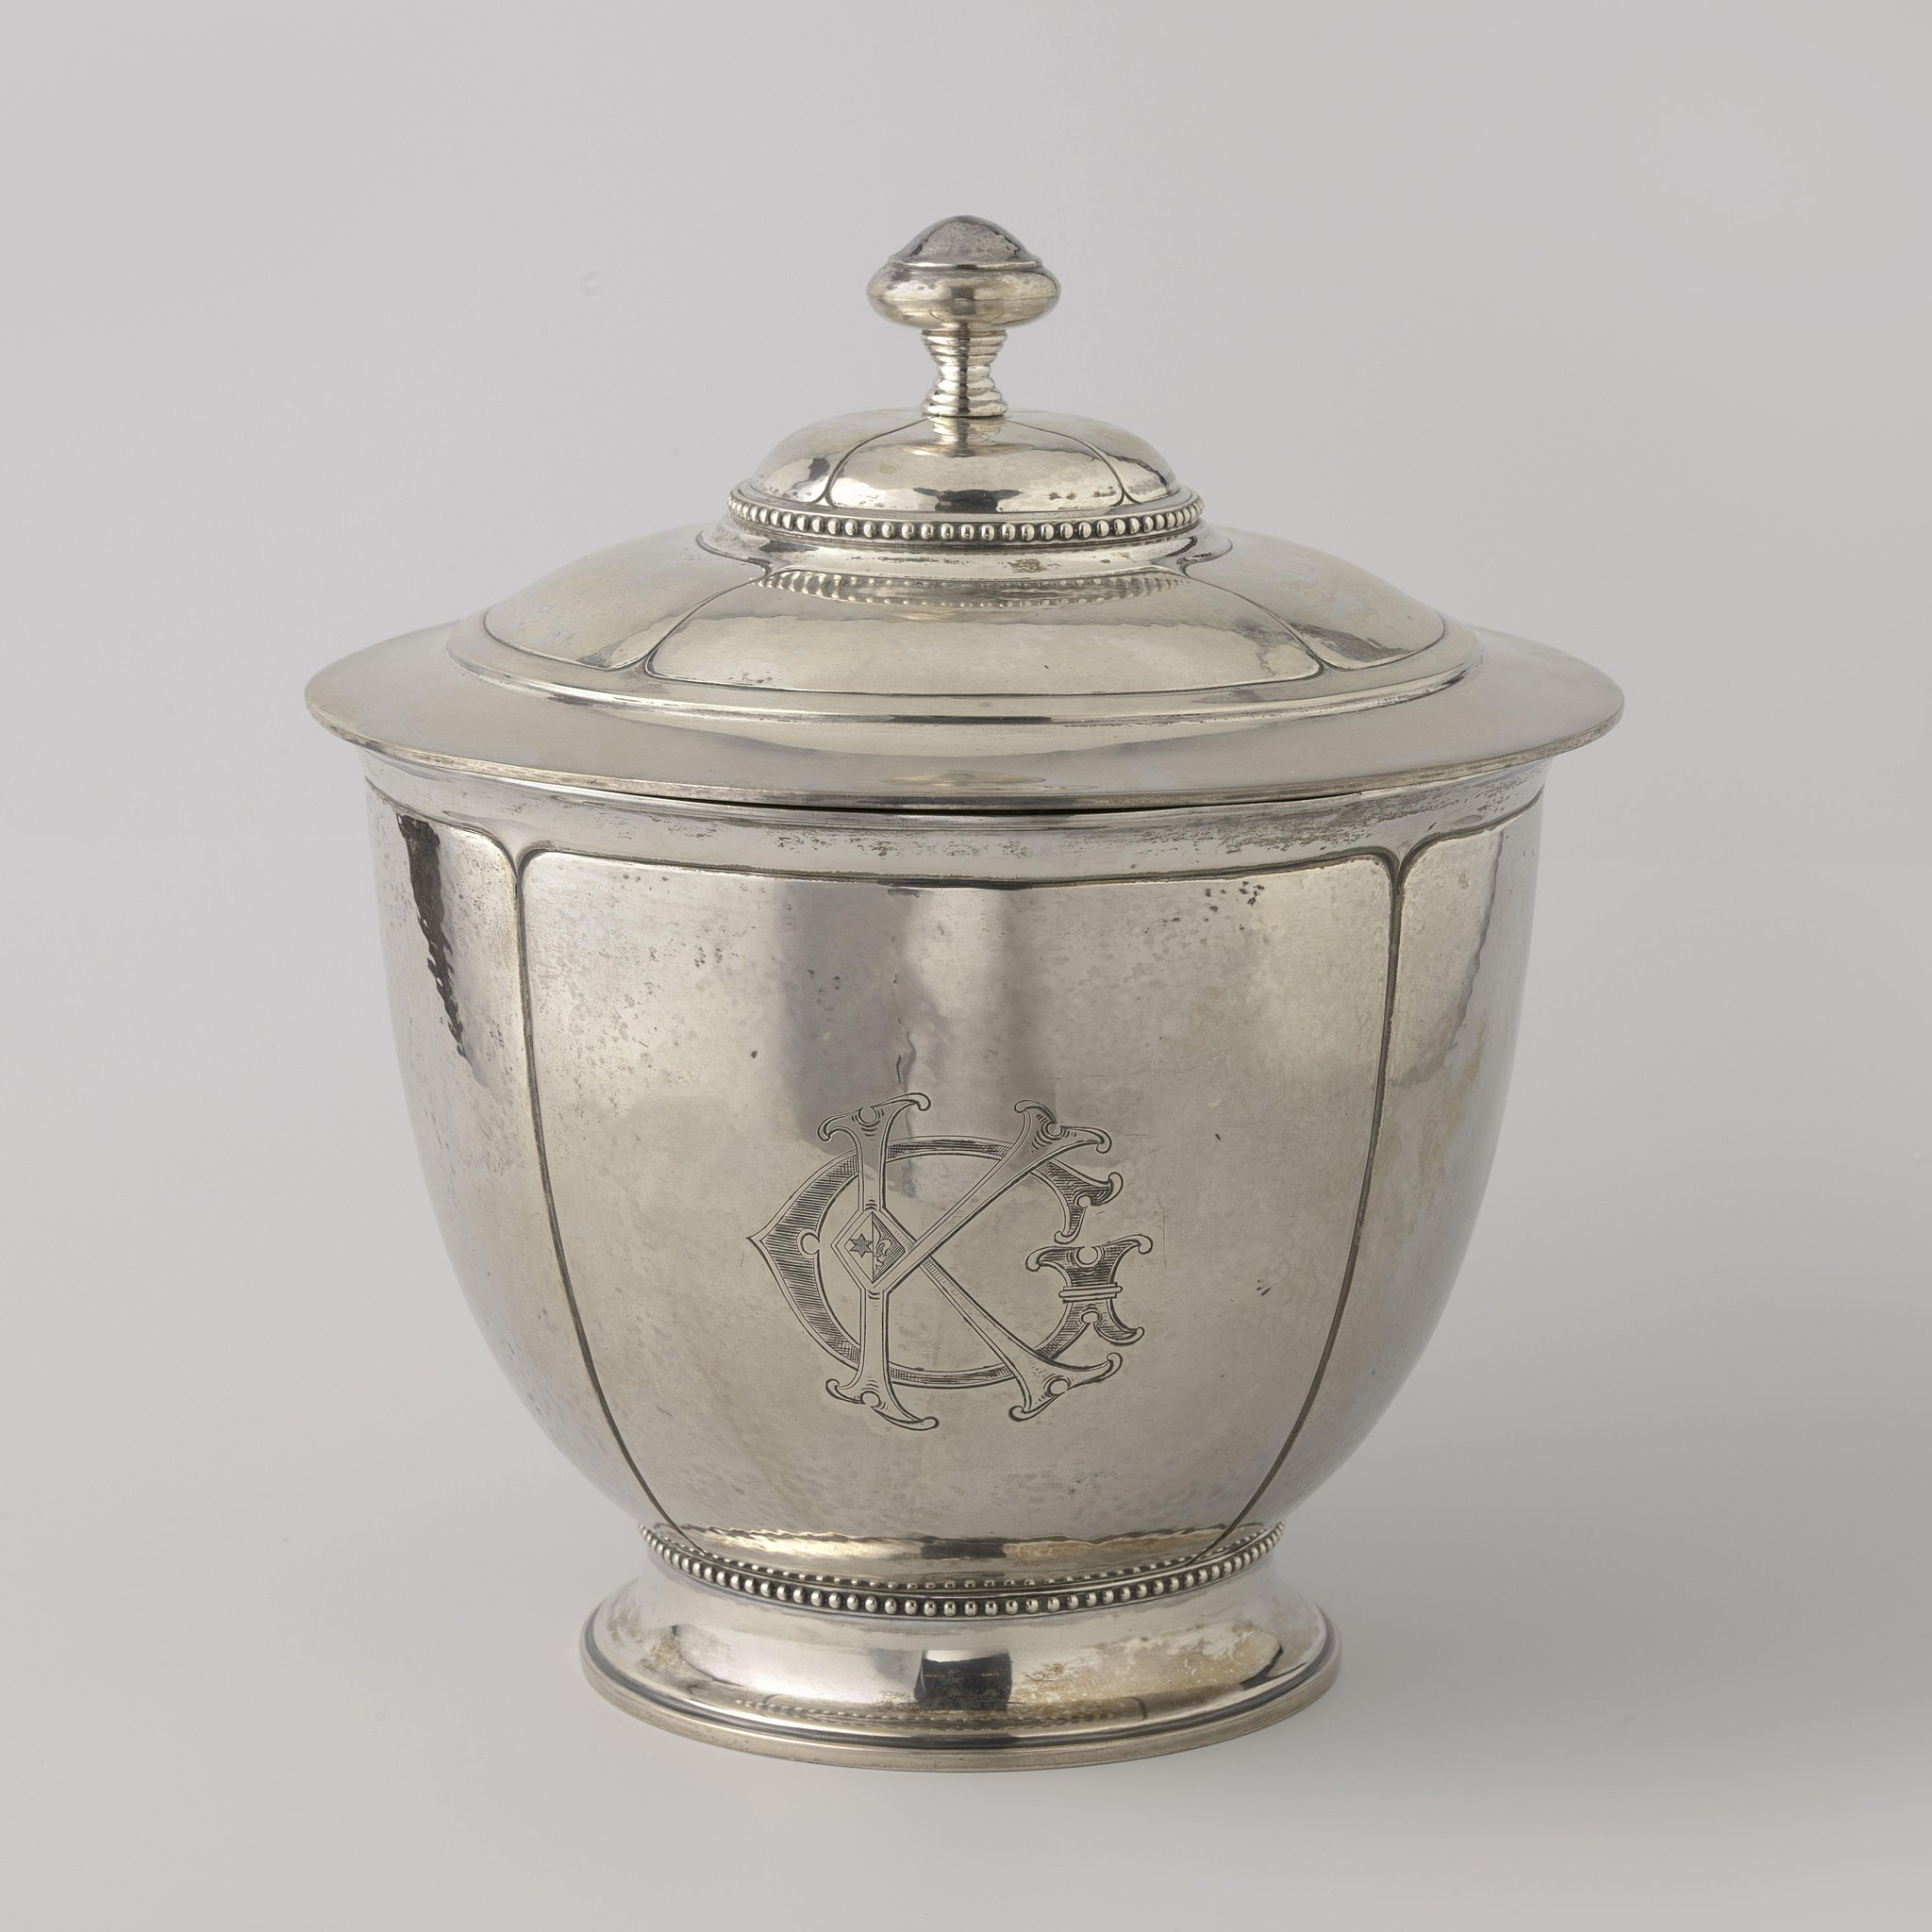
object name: tureen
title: Terrine van zilver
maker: carel begeer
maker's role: designer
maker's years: 1883-1956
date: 1912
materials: silver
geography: utrecht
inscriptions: mark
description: Ronde terrine van zilver, met deksel. De glade voet wordt afgesloten door een parelrand. Het hoge komvormige vat heeft een iets uitstaande liprand. het deksel heeft een brede concave rand, een gewelfd zich verjongend gedeelte en een bol bovenstuk met knop.